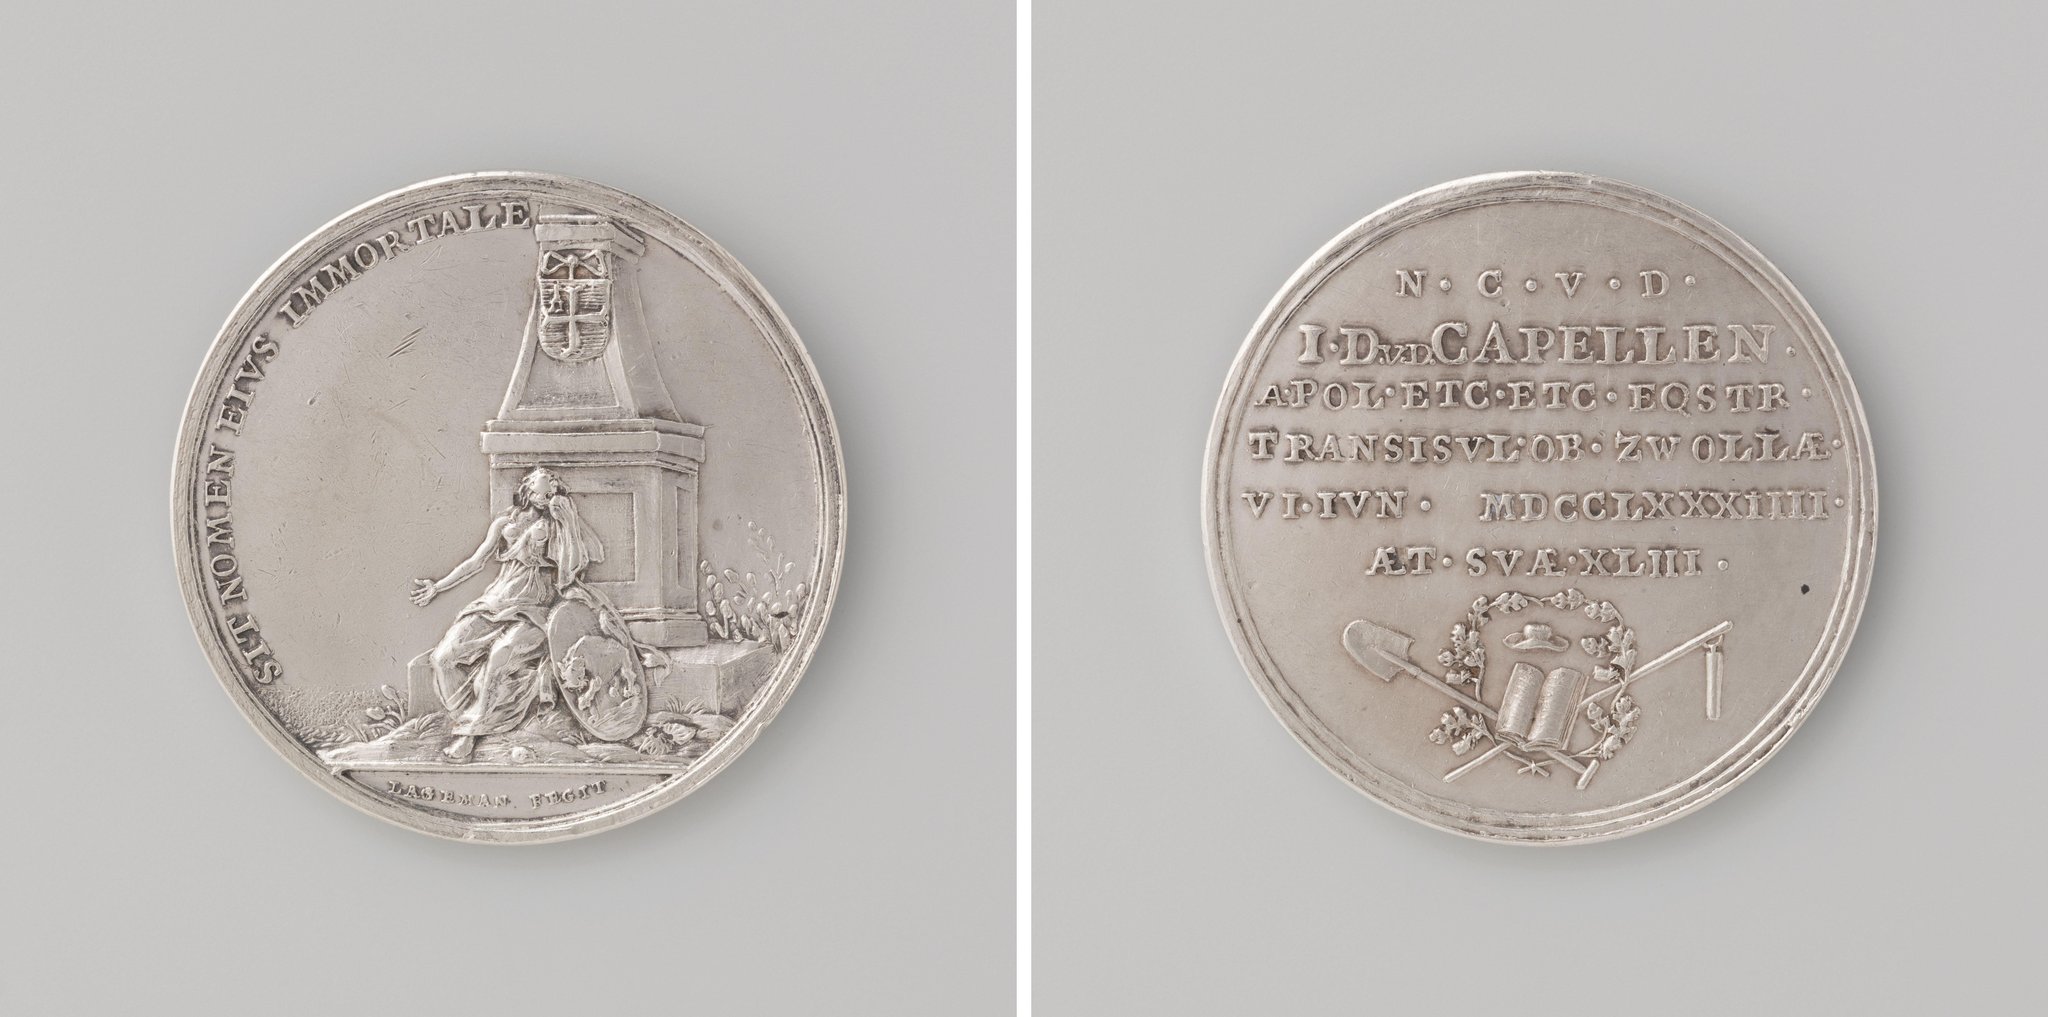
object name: family medal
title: Overlijden van Joan Derk van der Capellen tot den Pol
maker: johannes michiel lageman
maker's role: silversmith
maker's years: 1735-1809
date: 1784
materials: silver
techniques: striking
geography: amsterdam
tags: politician, joan derk van der capellen tot den pol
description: Zilveren penning. Voorzijde: rouwende vrouw met wapenschild, zittend aan voet van graftombe, waaraan wapenschild is opgehangen binnen omschrift; afsnede: signatuur. Keerzijde: opschrift boven vrijheidshoed, opengeslagen bijbel, spade en dorsvlegel binnen eikenkrans.